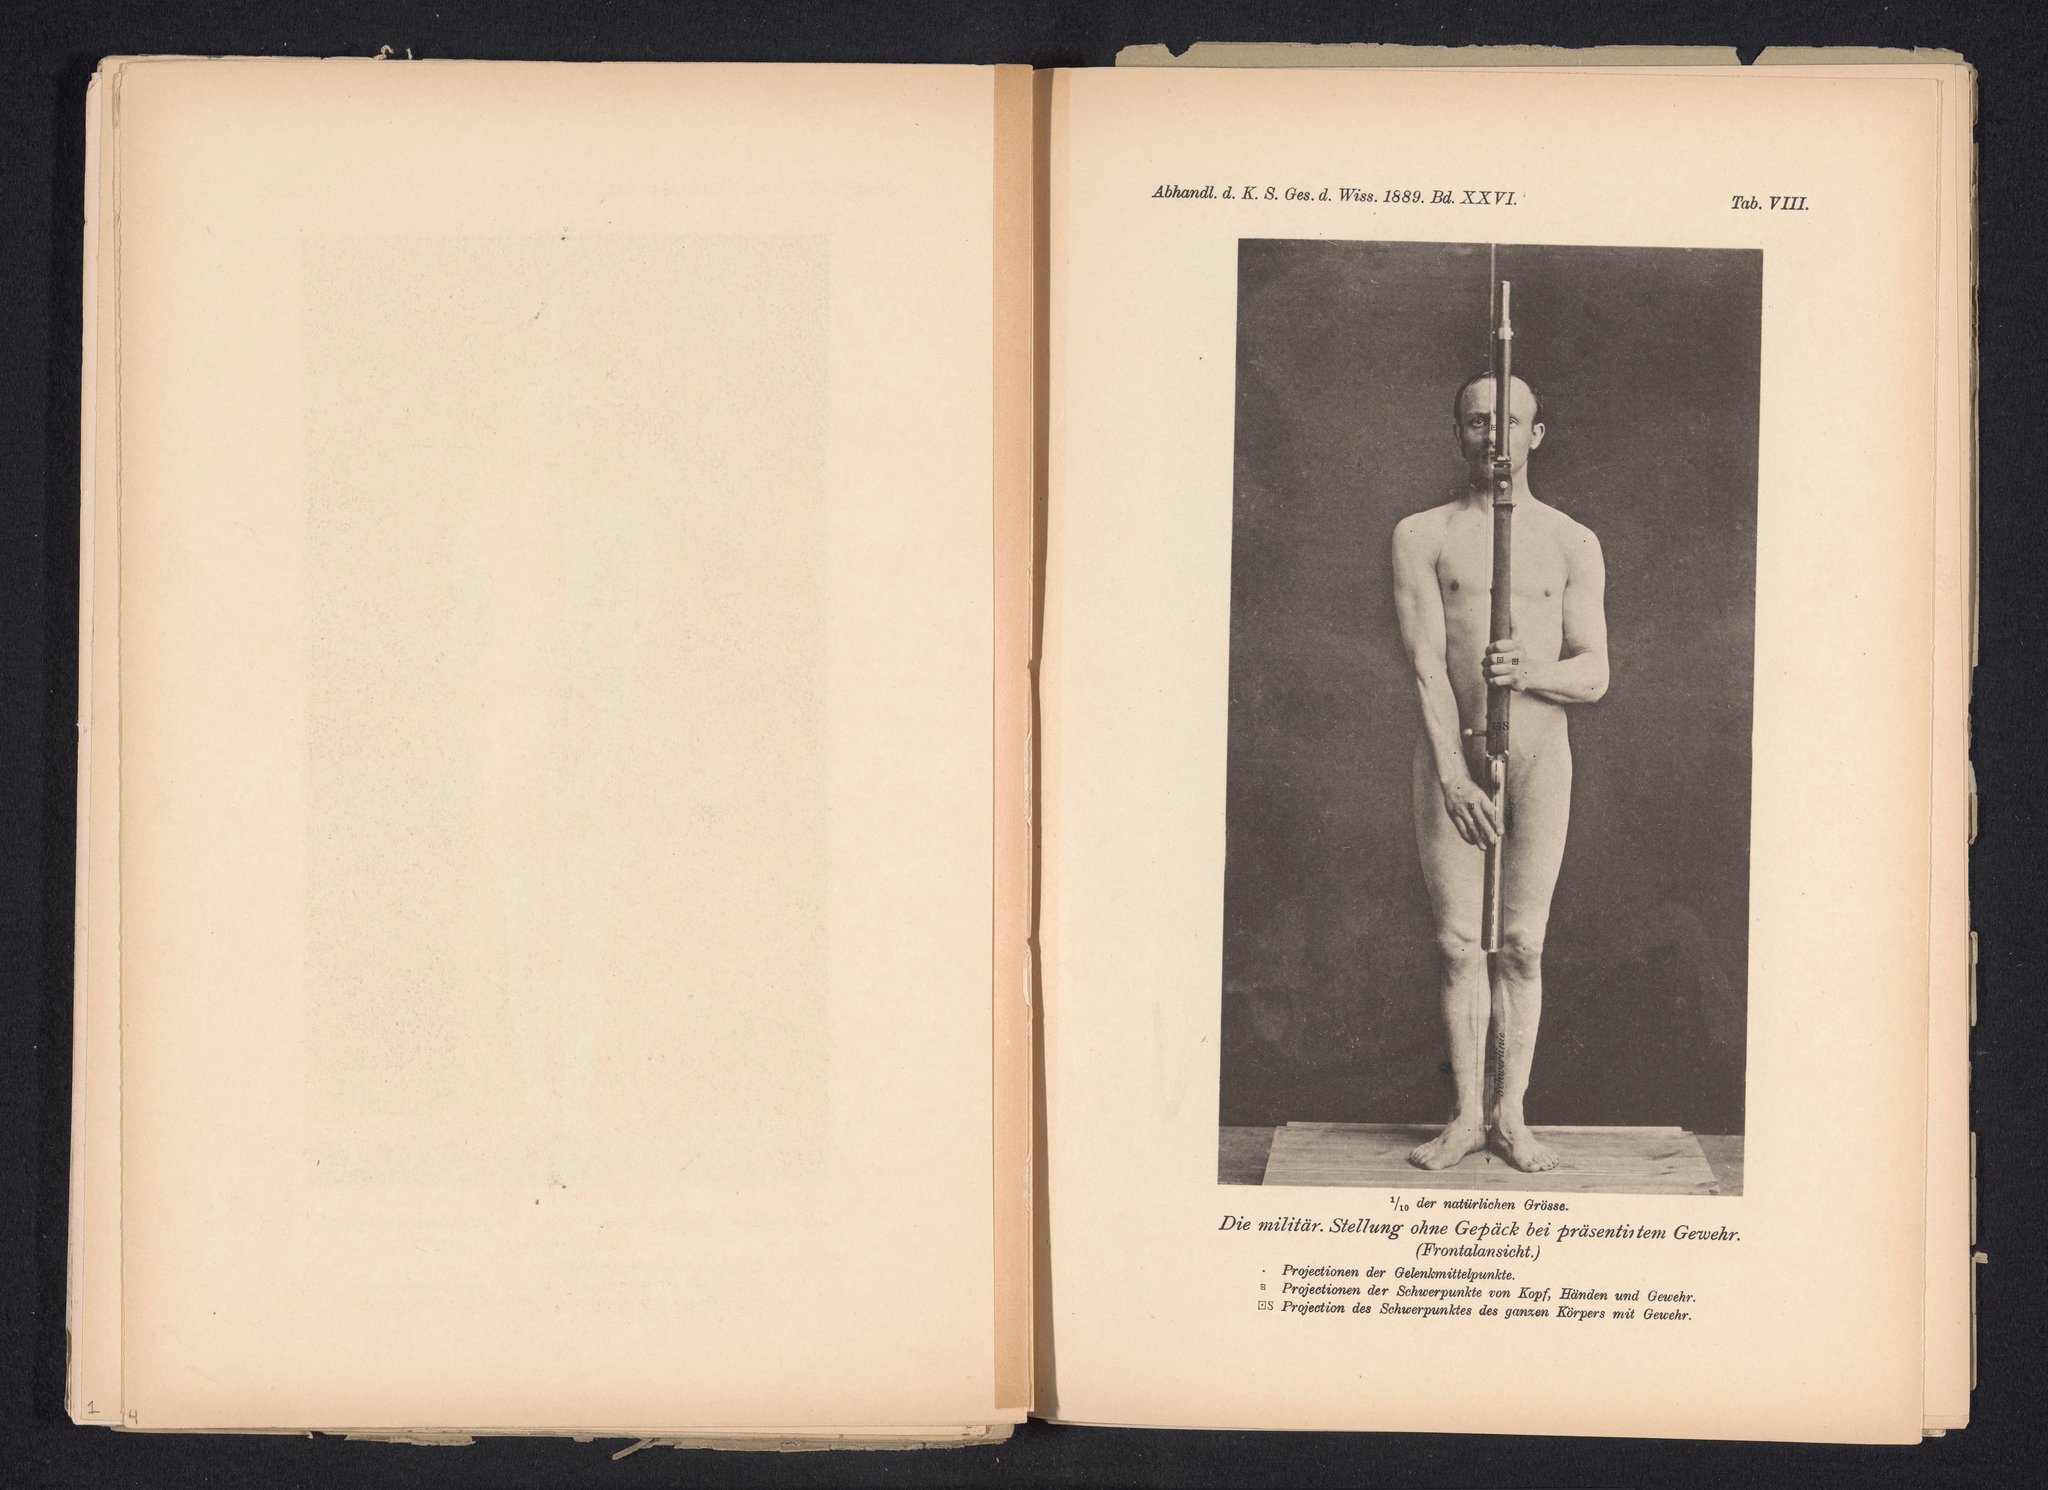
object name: page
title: Onbekende naakte man, en face met een geweer in zijn handen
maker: Anonymous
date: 1880-1890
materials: paper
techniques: photograph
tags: anatomy (non-medical), firearms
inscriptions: inscription: ‘Schwerlinie. 1/10 der natürlichen Grösse. Projectionen der Gelenkmittelpunkte. Projectionen der Schwerpunkte von Kopf, Händen und Gewehr. Projection des Schwerpunkte des ganzen Körpers mit Gewehr.’, number: ‘Tab. VIII.’